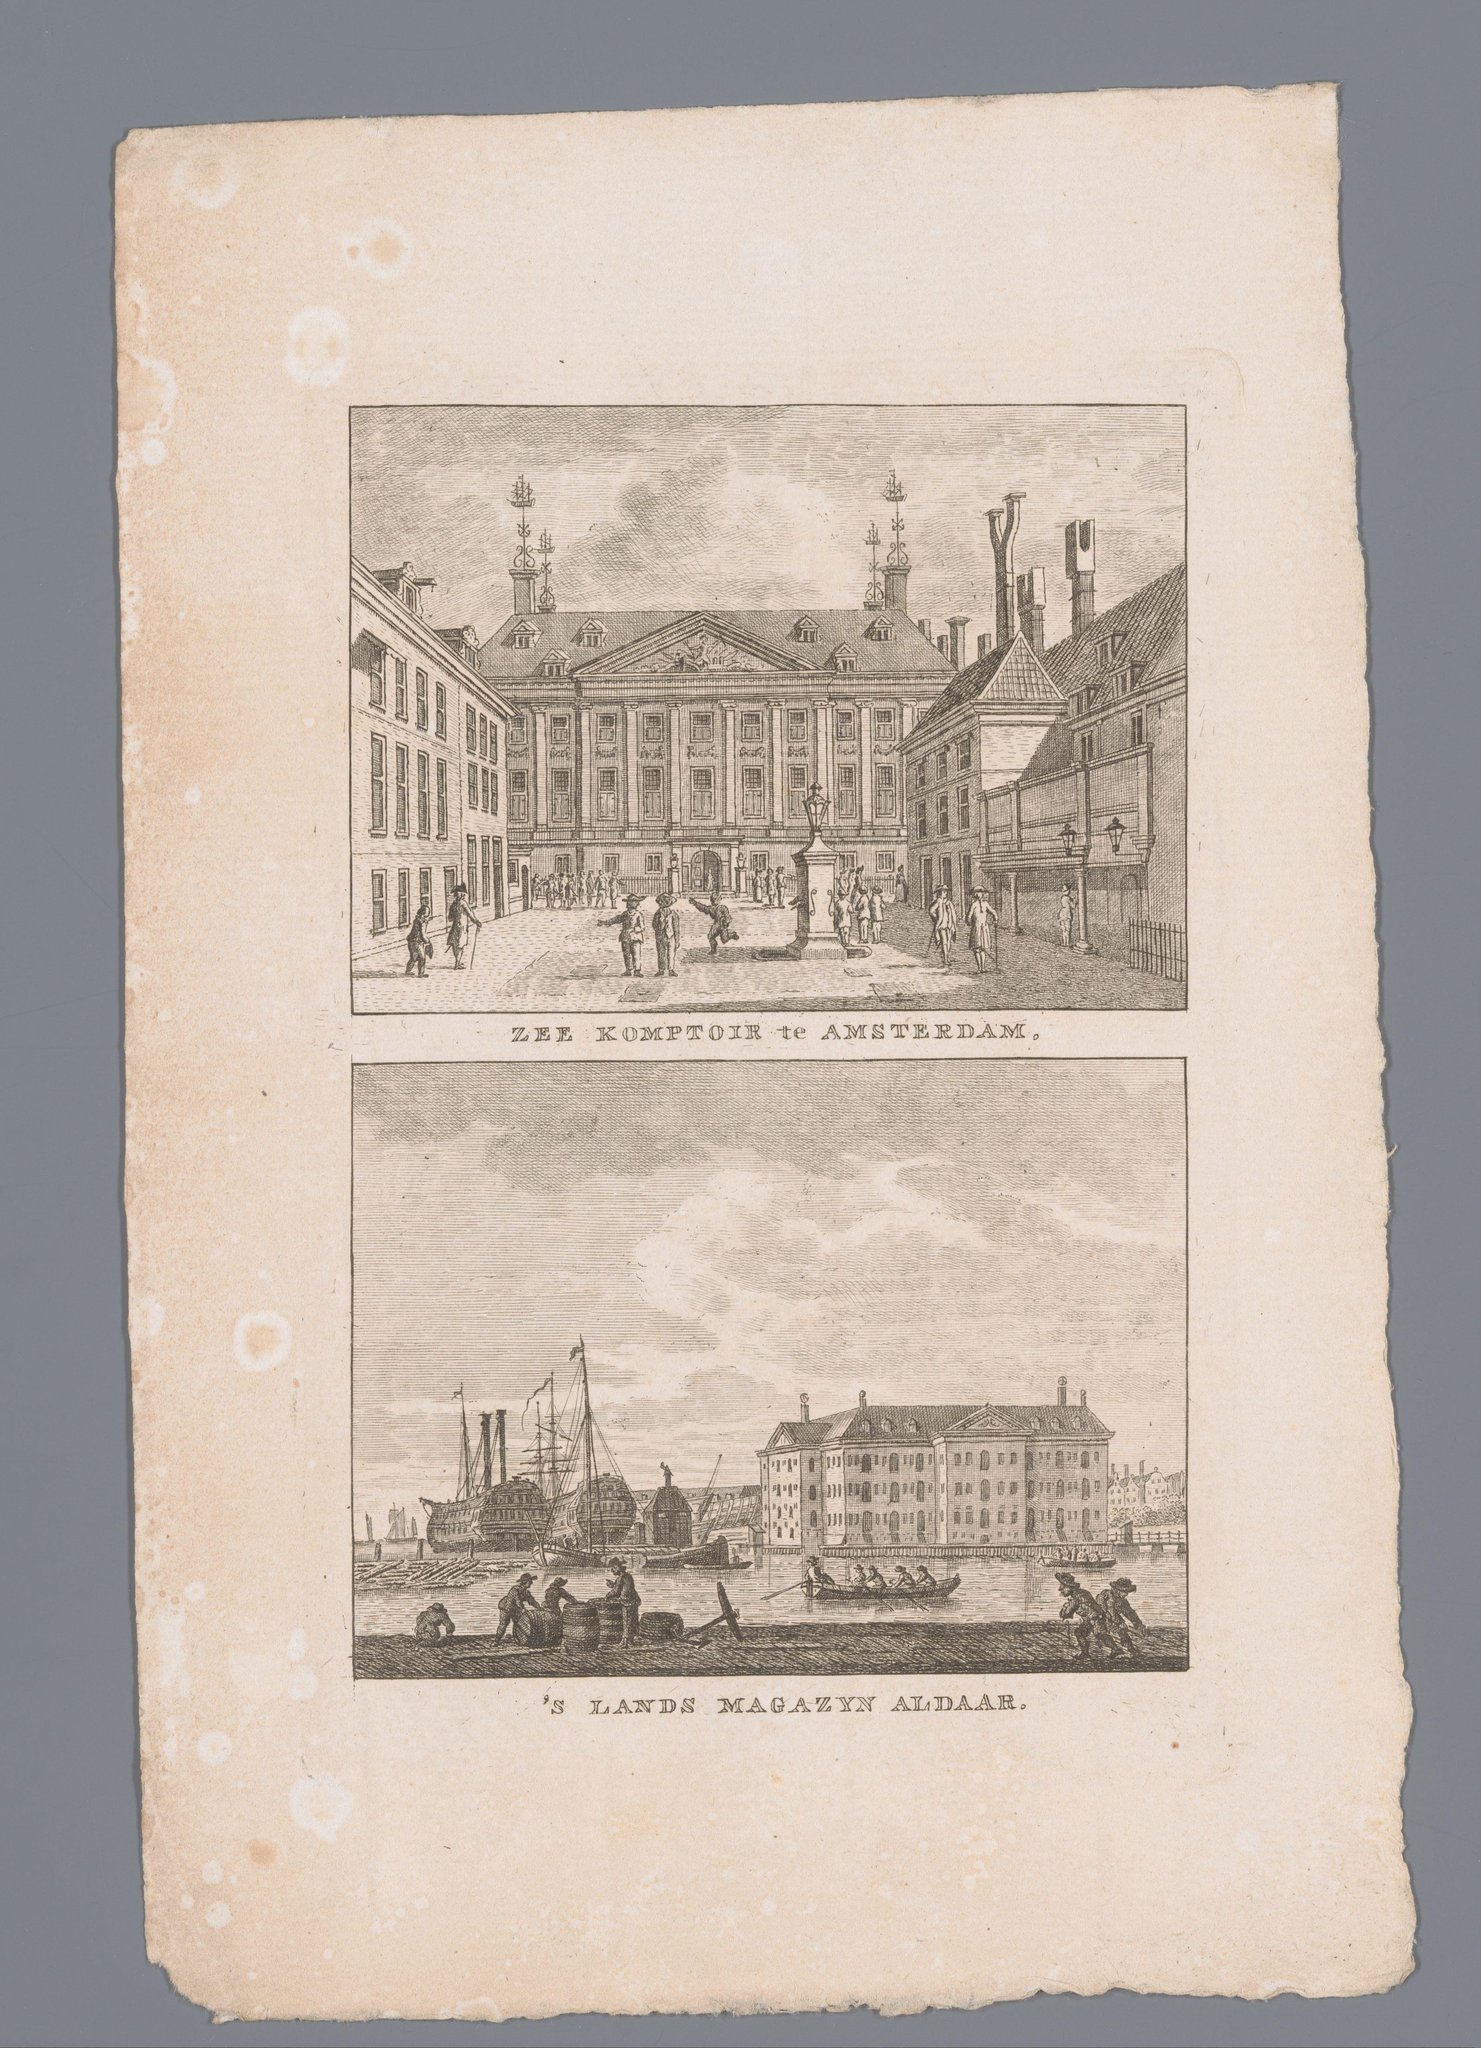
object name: print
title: Zee komptoir te Amsterdam; 's Lands magazyn aldaar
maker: carel frederik bendorp (i)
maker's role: print maker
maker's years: 1736-1814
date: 1786-1792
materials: paper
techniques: etching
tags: large-scale structure for storage, e.g.: warehouse, depot, silo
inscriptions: collector's mark: Lugt 2233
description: Prent uit: Vaderlandsche gezichten, of afbeeldingen van den tegenwoordigen staat der Vereenigde Nederlanden (…). Amsterdam: Hendrik Gartman, Willem Vermandel en Jan Willem Smit, 1786-1792. Uitgegeven in afleveringen met ieder een eigen bifolium en inhoudsopgave. Alle prenten in deze publicatie zijn gegraveerd door Carel Frederik Bendorp (I) en, in de meeste gevallen, gebaseerd op tekeningen van Jan Bulthuis.